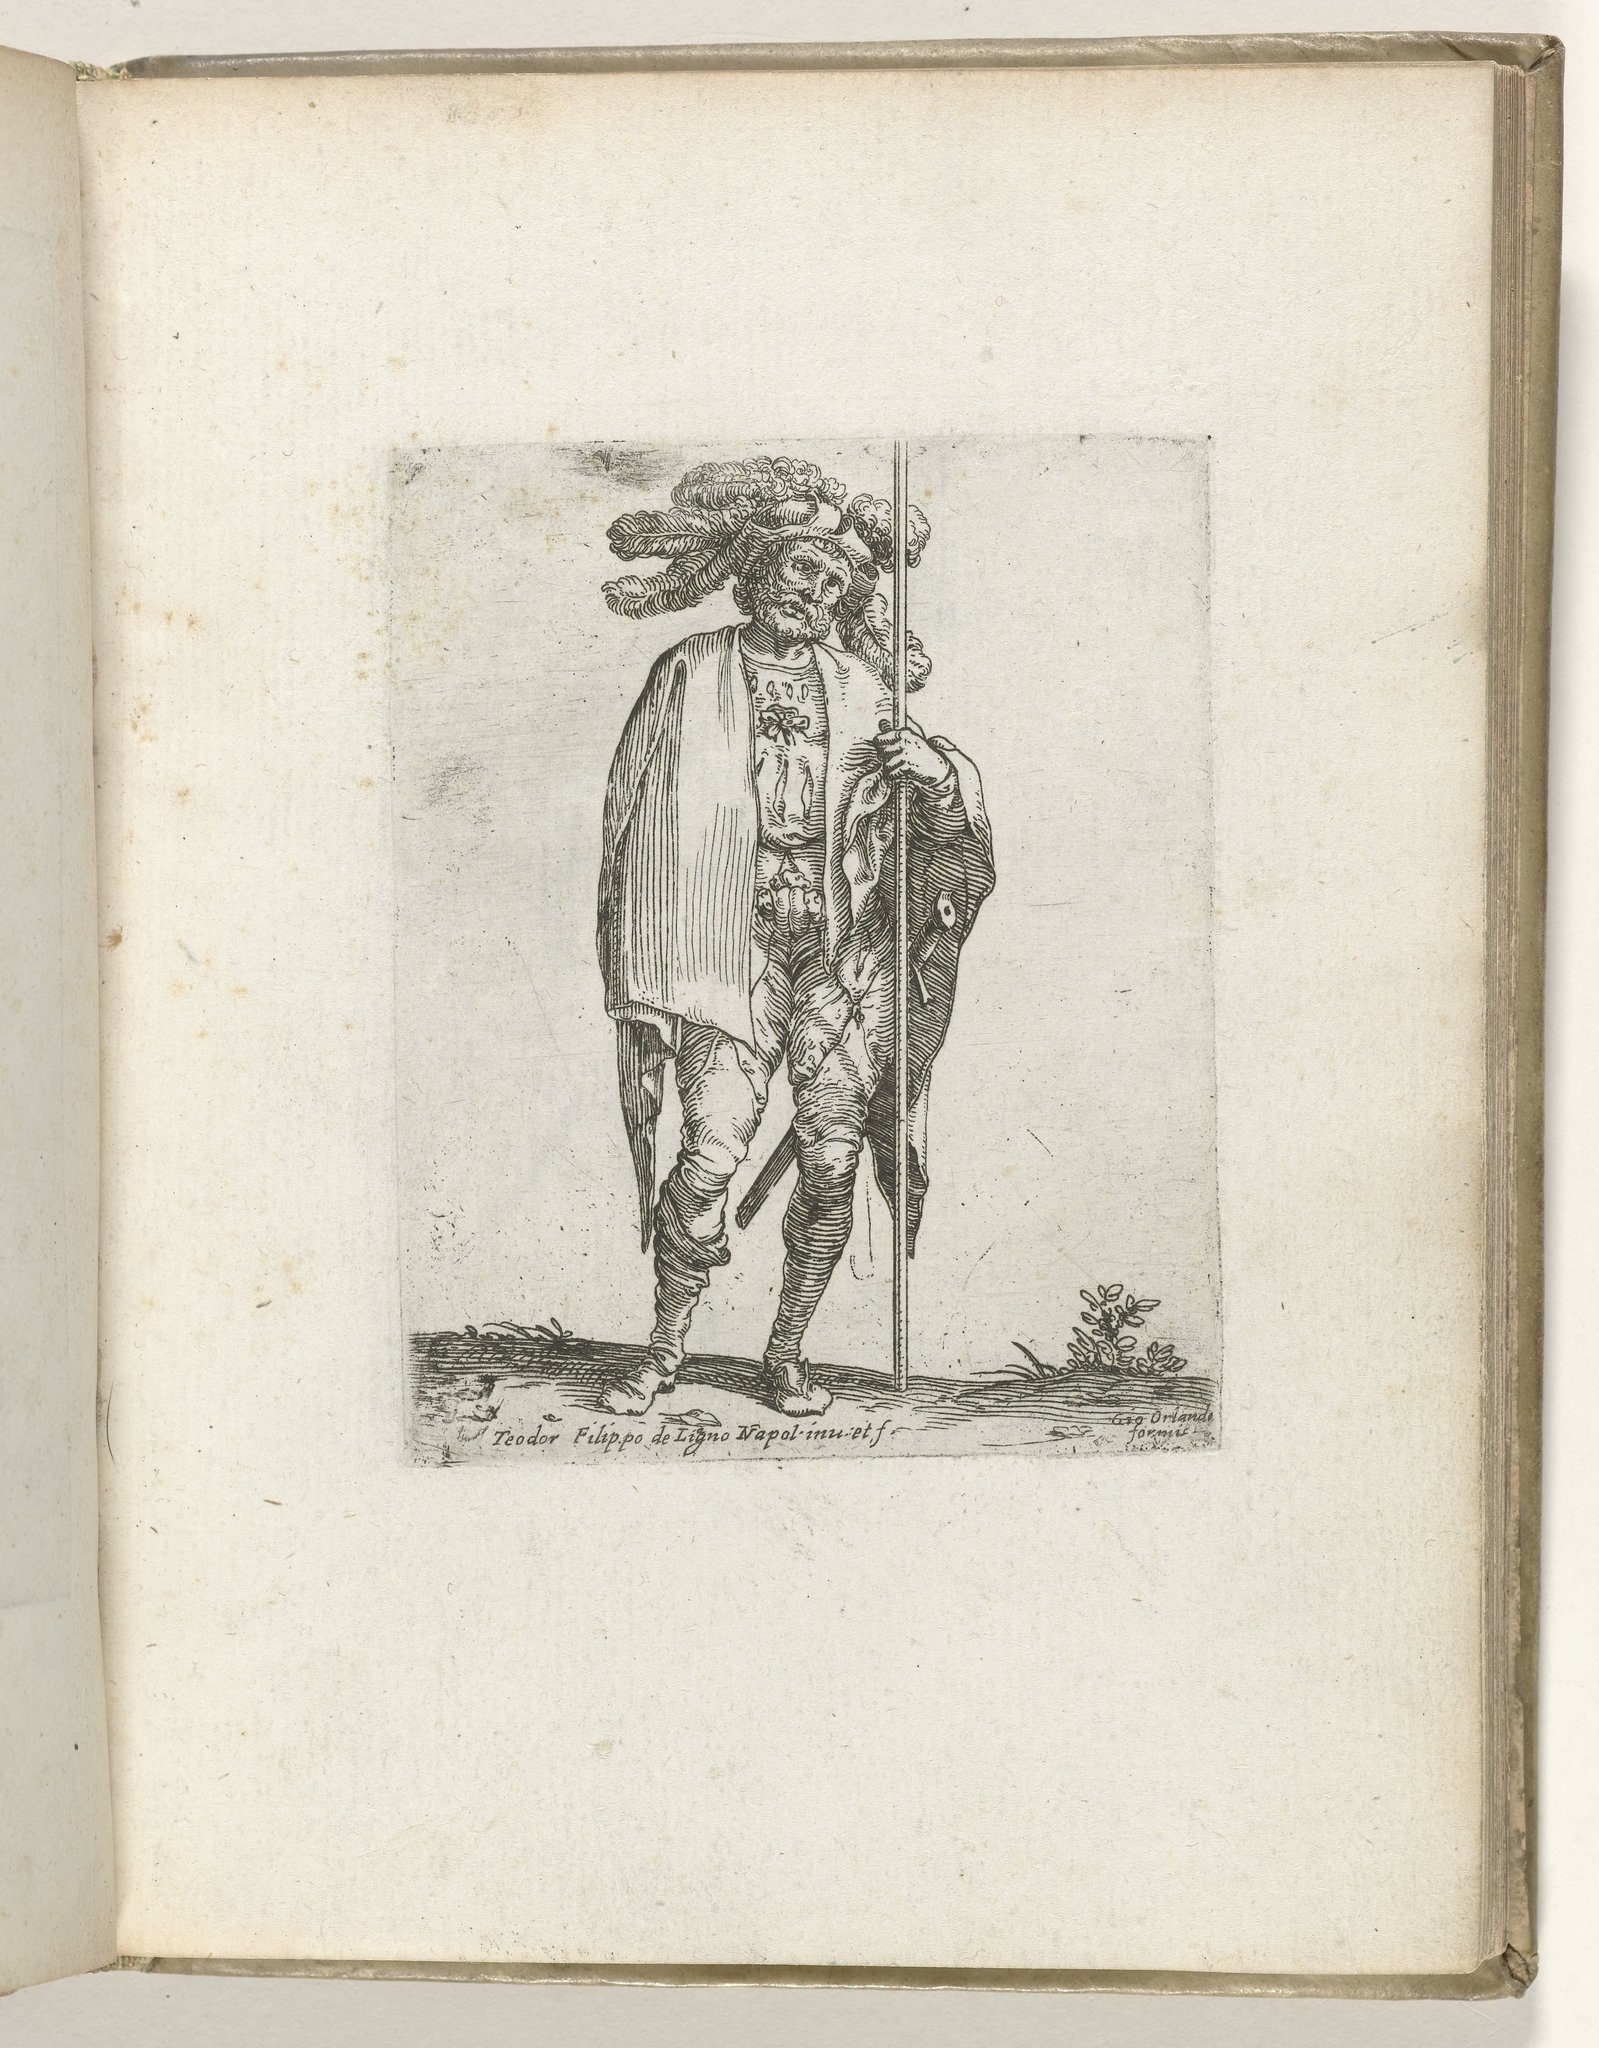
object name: costume print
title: Krijgsman met lans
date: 1597-1629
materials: paper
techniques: etching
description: Prent mogelijk later aan het album toegevoegd, dat stamt uit 1558.